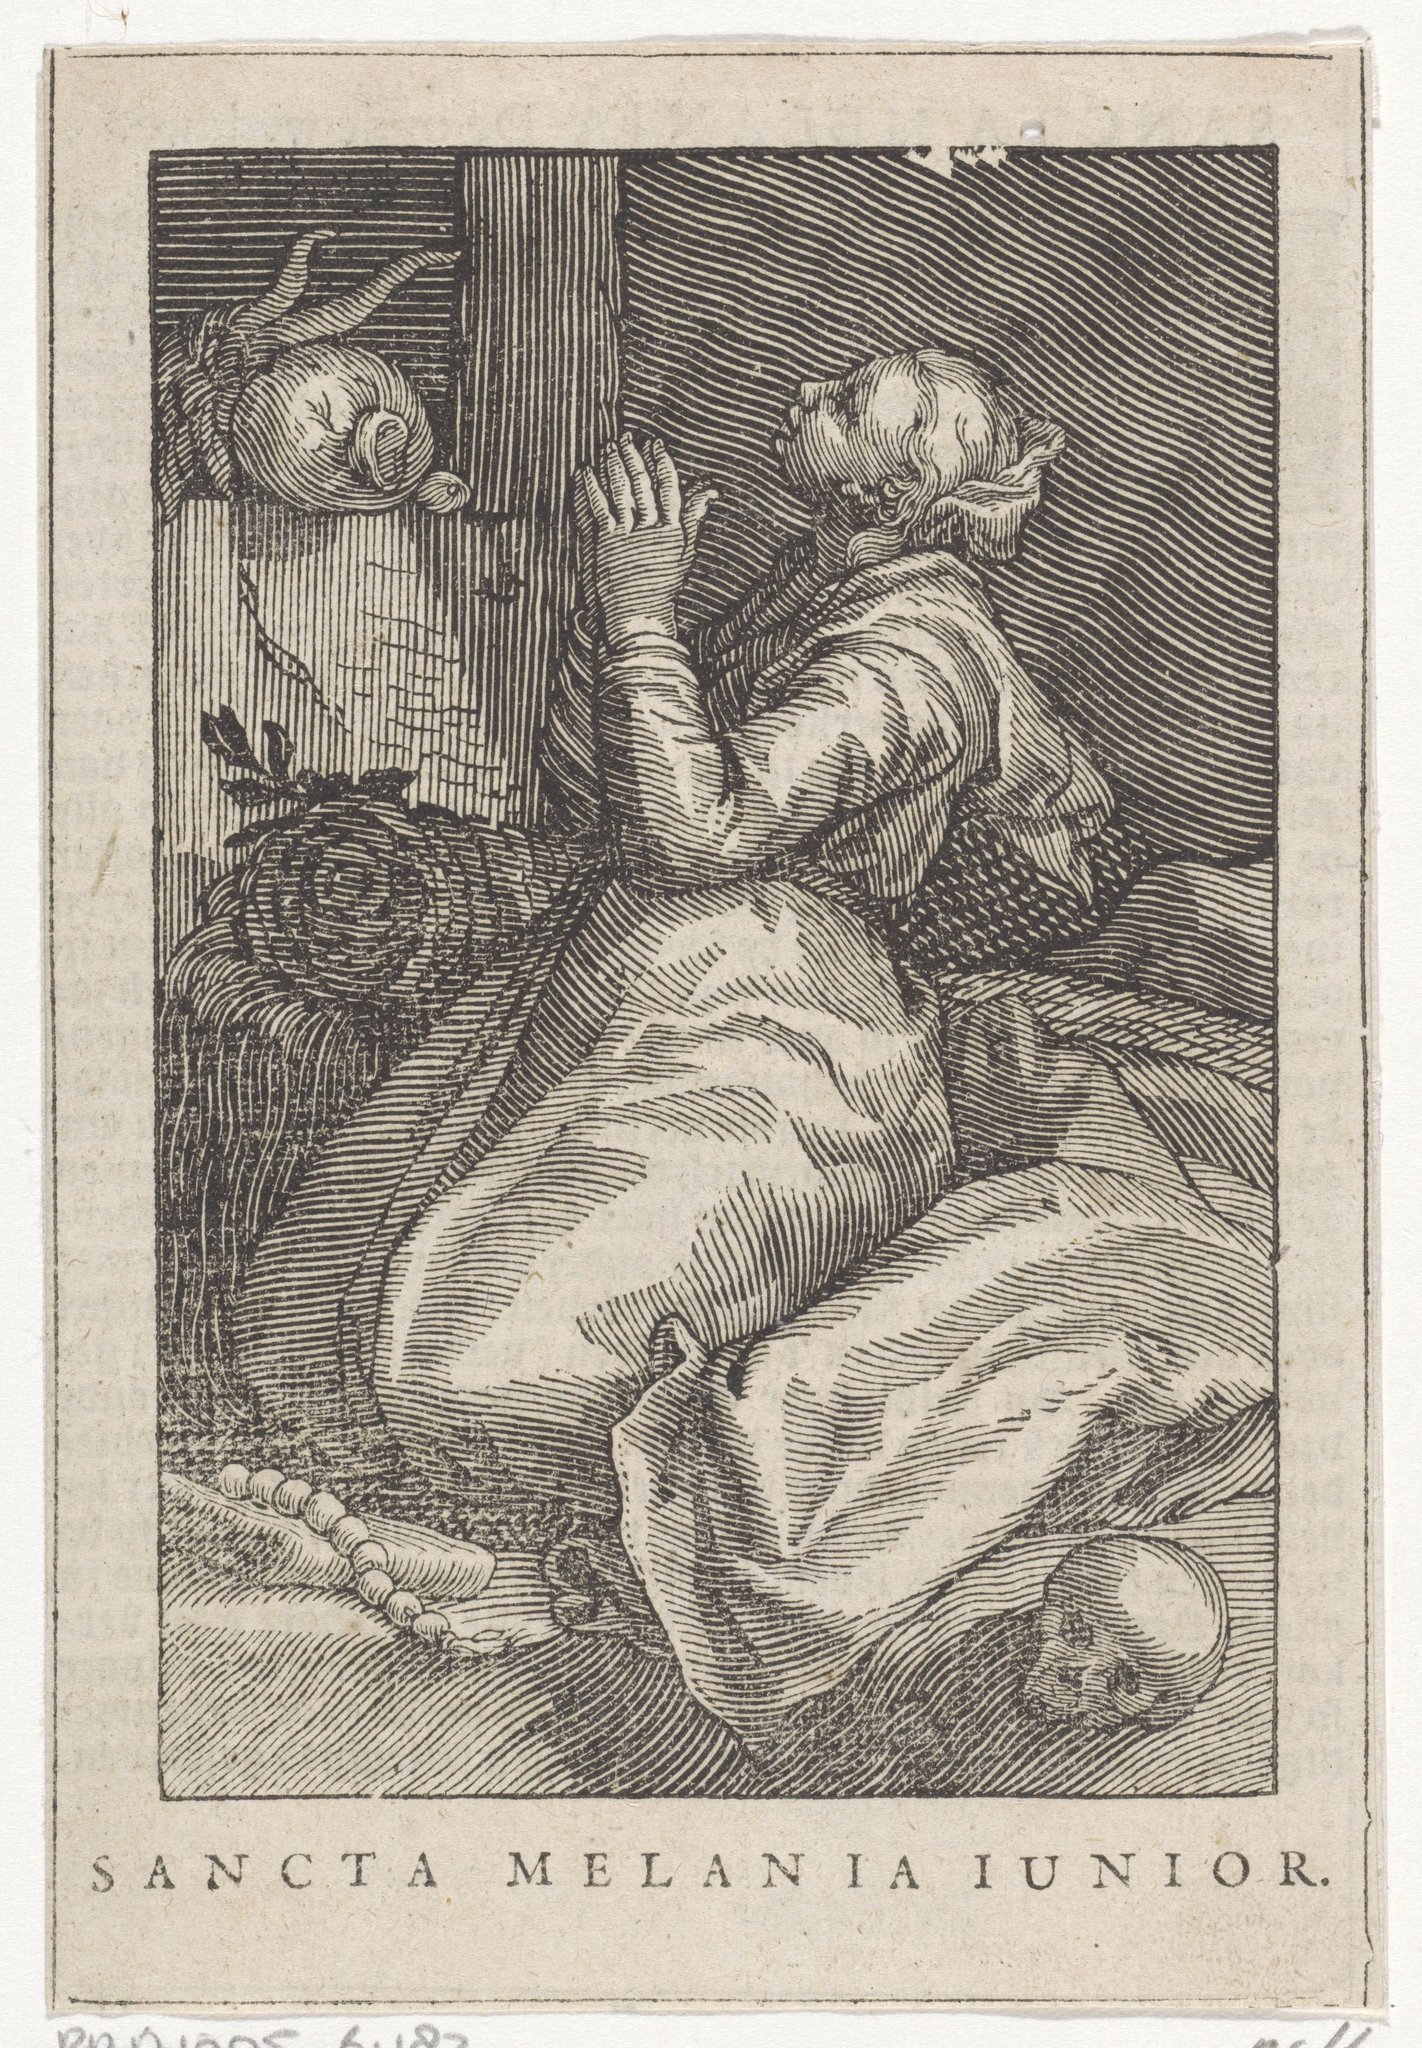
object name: print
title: Heilige Melania de Jongere als kluizenares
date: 1644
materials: paper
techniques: letterpress printing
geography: amsterdam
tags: female saints (with name), anchorite, hermit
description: Prent uit: Rosweyde, Heribert. 'tBosch der eremyten ende eremitinnen, van Aegypten ende Palestinen. Amsterdam: Pieter Jacobsz. Paets, 1644.